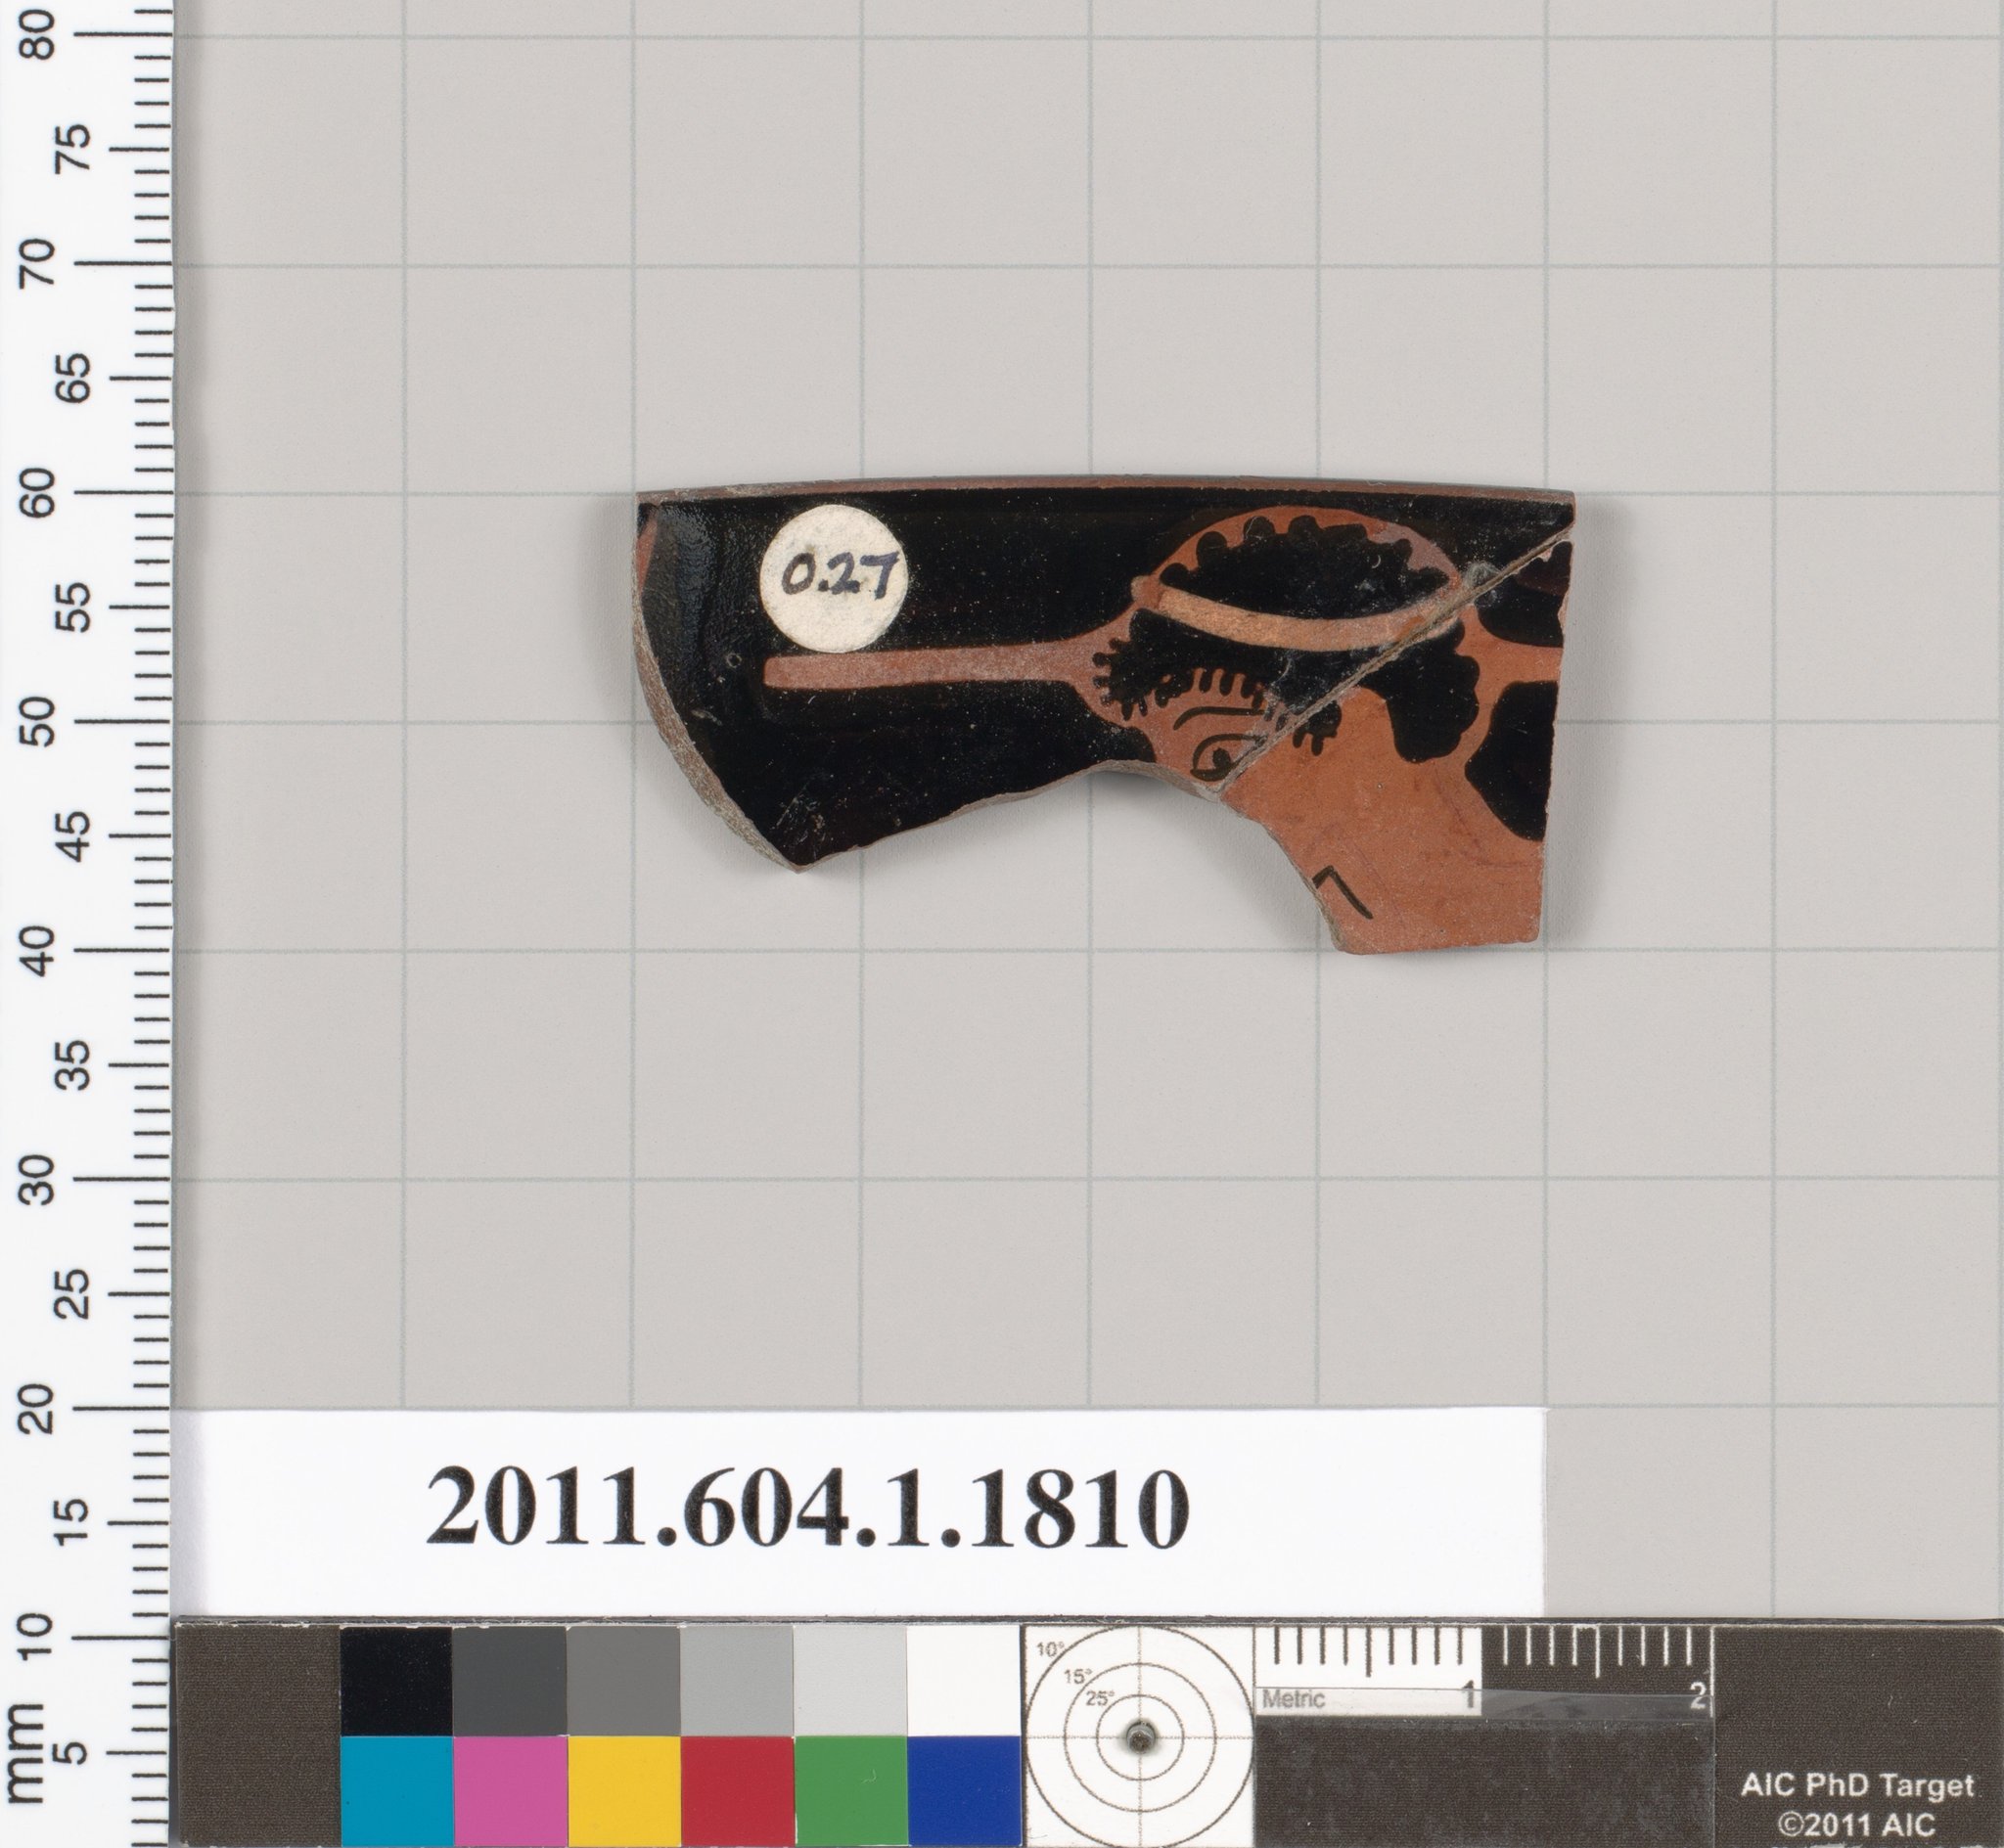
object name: kylix fragment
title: Terracotta rim fragment of a kylix (drinking cup)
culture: greek, attic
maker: painter of berlin 2268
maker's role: artist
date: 520-510 BCE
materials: terracotta